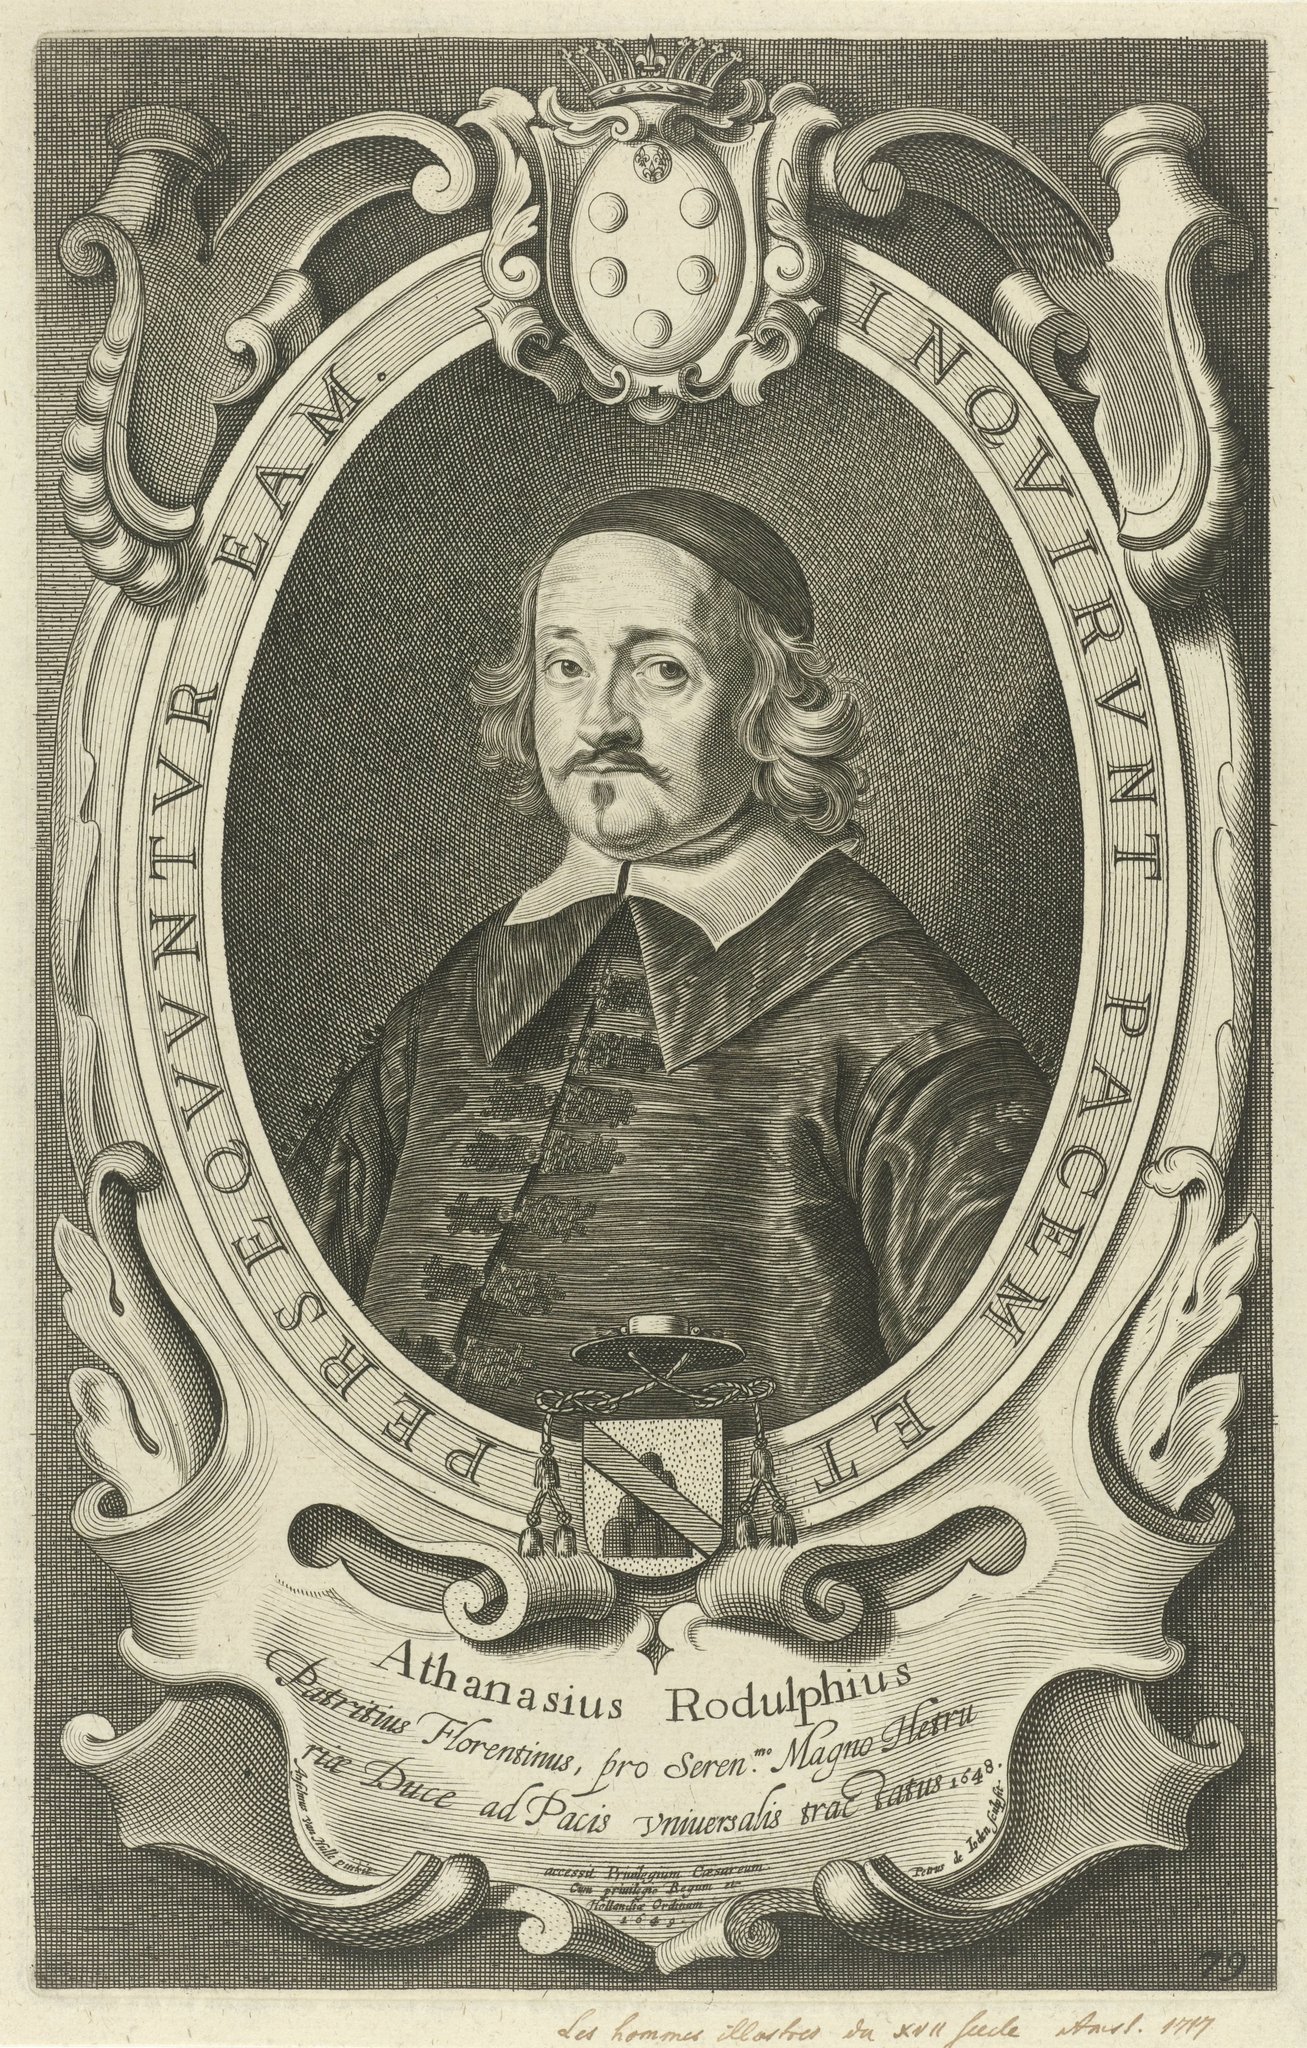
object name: print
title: Hommes illustres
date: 1649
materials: paper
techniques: engraving, etching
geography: antwerp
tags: atanasio ridolfi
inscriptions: collector's mark: Lugt 2228, inscription: ‘Les hommes illustres [...] Amst. 1717’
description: Busteportret van Atanasio Ridolfi, met kalot. Rechtsonder: 79. Het portret is gevat in een ovale omlijsting met het wapenschild van de geportretteerde, decoraties en een randschrift in het Latijn. In de cartouche een drieregelig onderschrift in het Latijn. Prent uit een serie portretten naar schilderijen van Anselmus van Hulle van alle gedelegeerden bij de vredesonderhandelingen te Münster en Osnabrück.